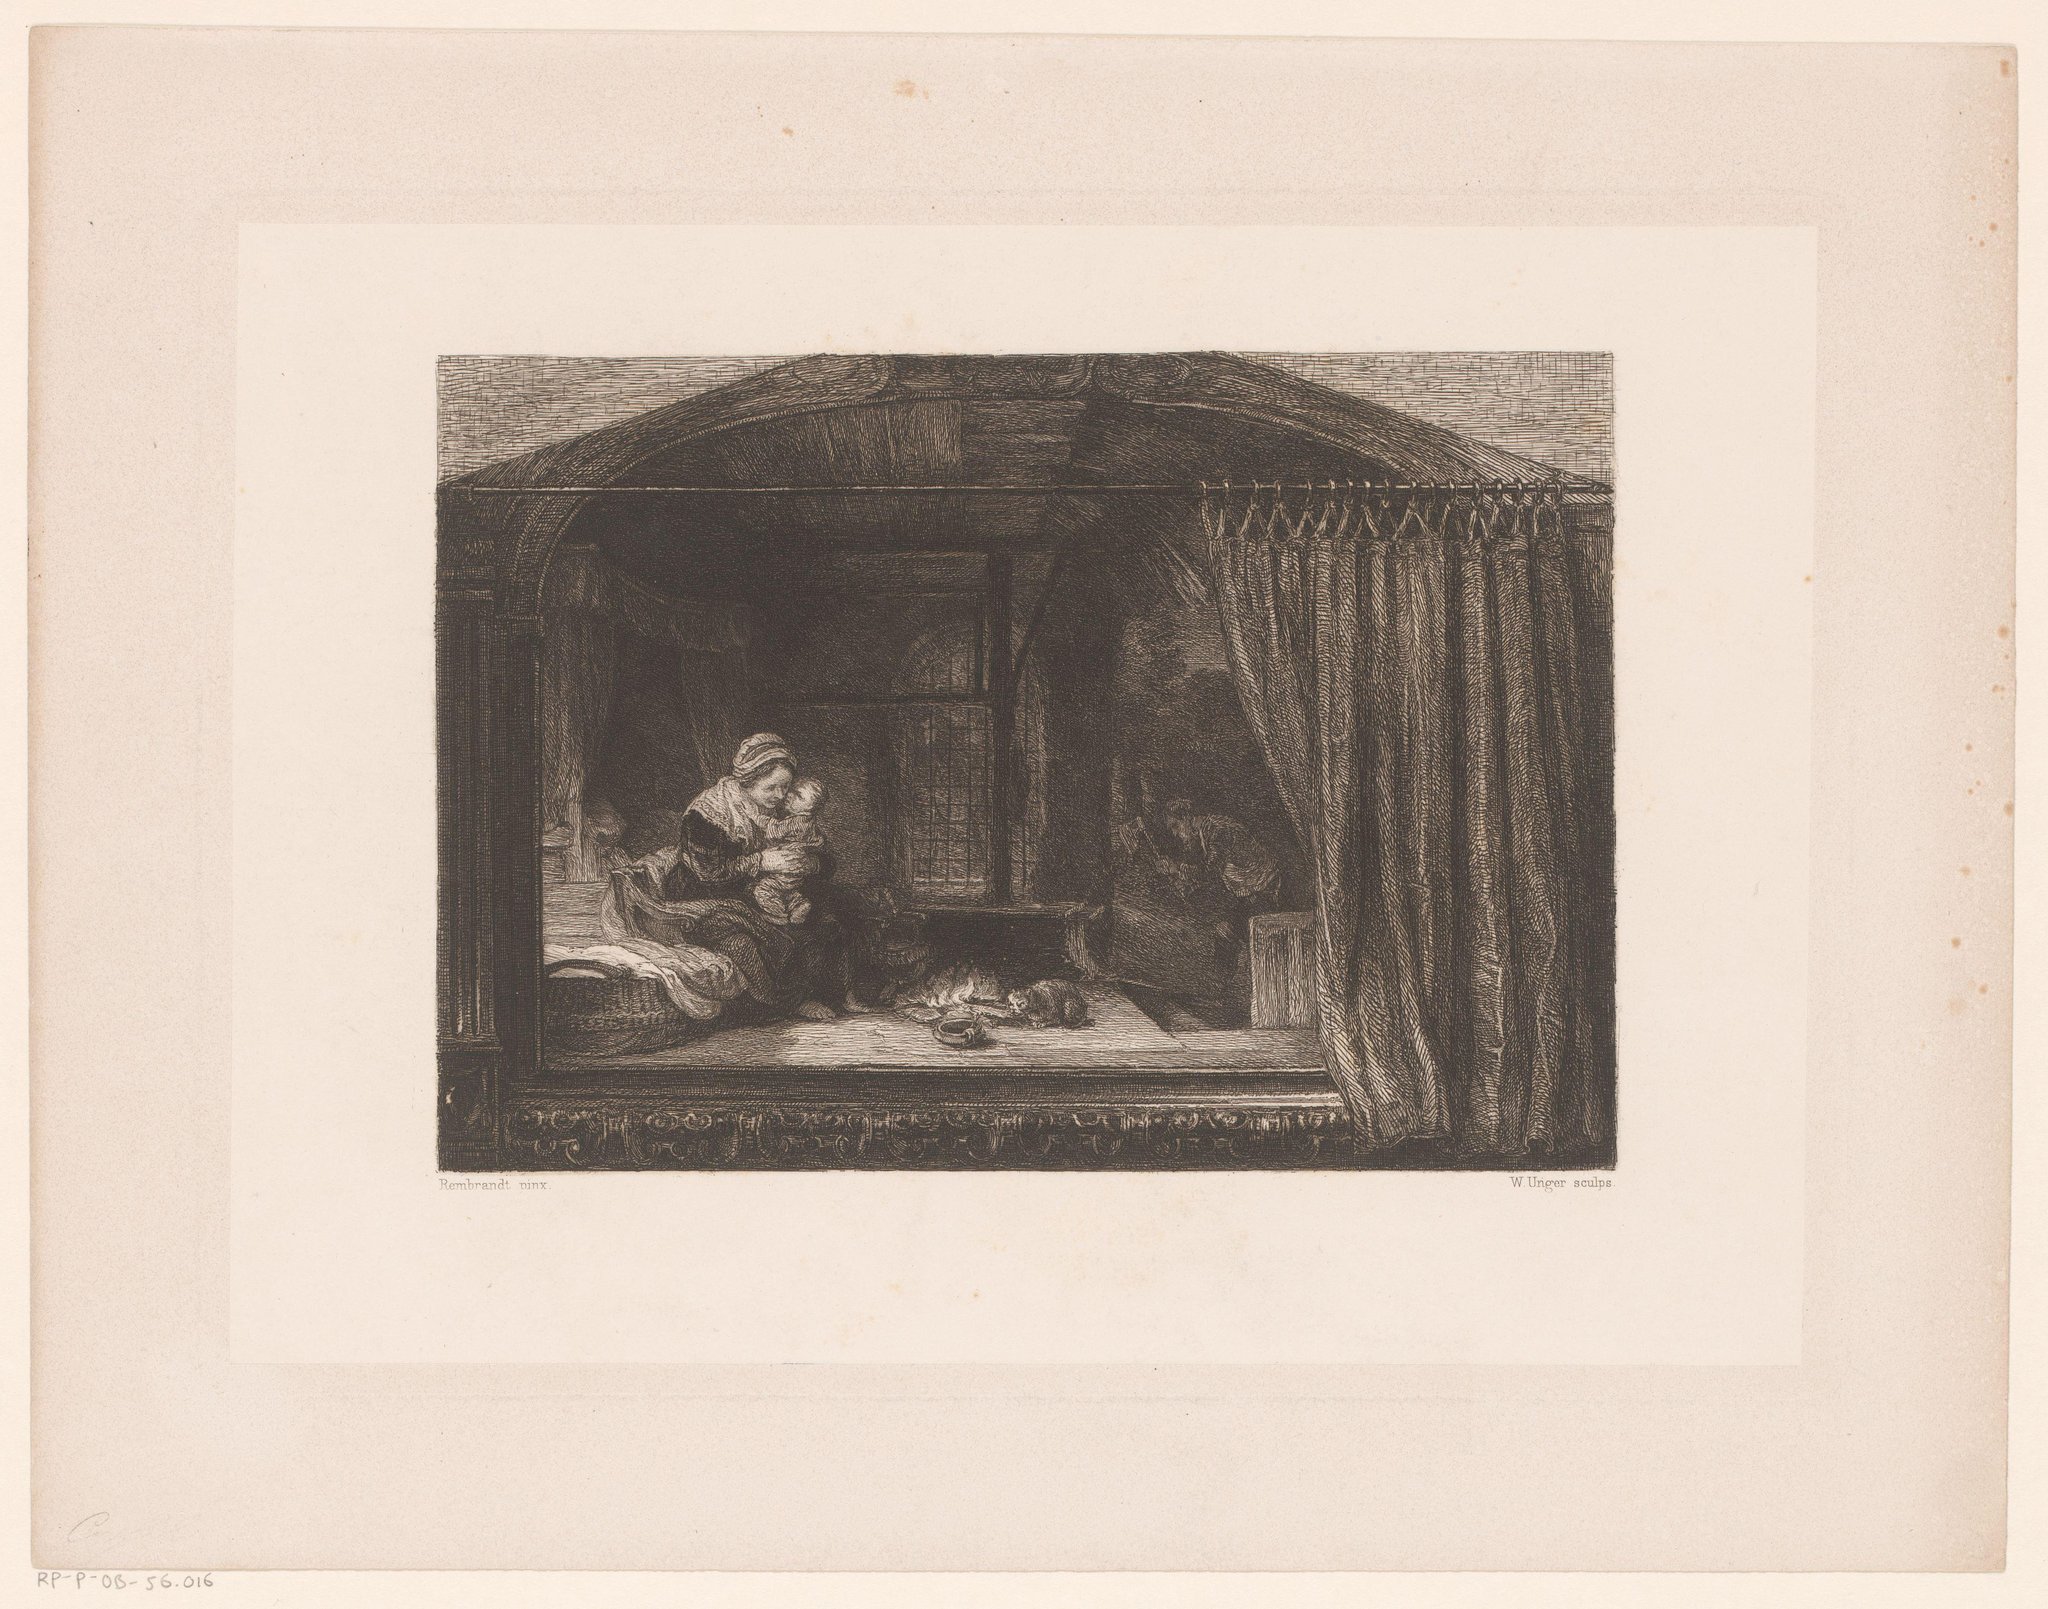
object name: print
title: Heilige Familie in een interieur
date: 1847-1889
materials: paper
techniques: etching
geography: germany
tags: cat, holy family, and derived representations, (feigned) picture curtain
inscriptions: collector's mark: Lugt 2228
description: Prent naar het schilderij door Rembrandt Harmensz. van Rijn in de Gemäldegalerie Alte Meister te Kassel (inv.nr. GK 240).